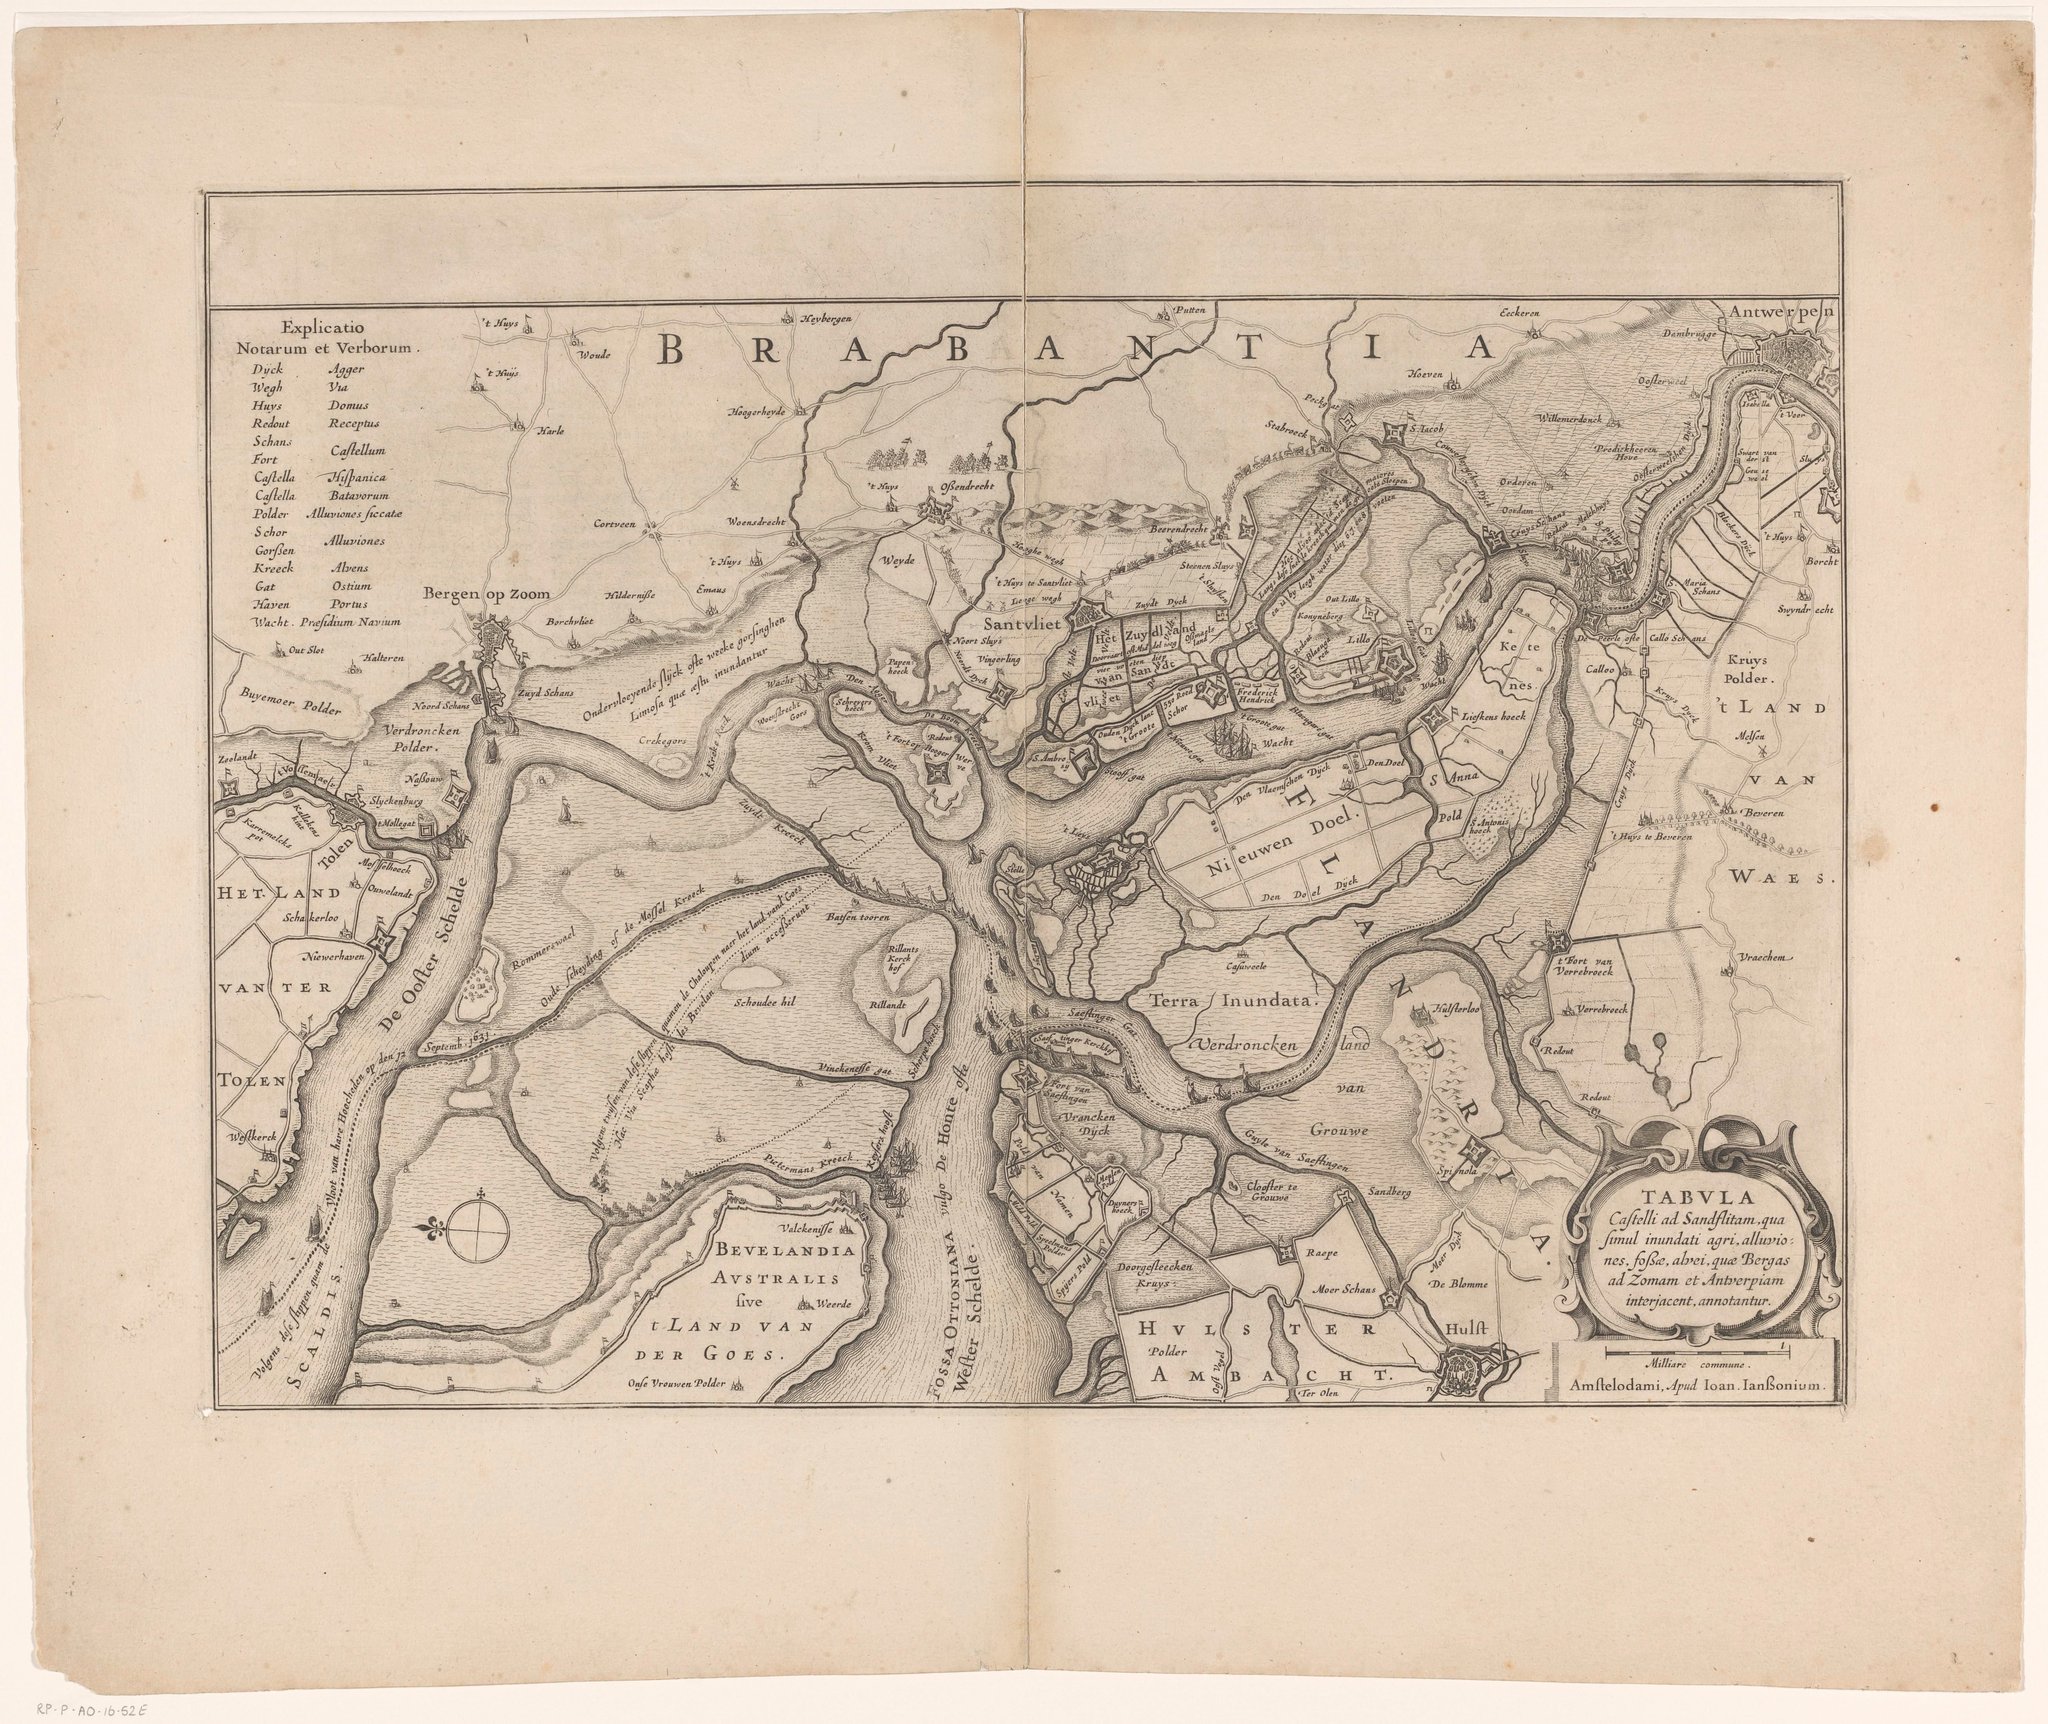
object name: print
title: Tabula castelli ad Sandflitam, qua simul inundati agri, alluviones, fossae, alvei, quae Bergas ad Zomam et Antverpiam interjacent, annotantur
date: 1652-1658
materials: paper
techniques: engraving, etching, letterpress printing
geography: amsterdam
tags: delft, the hague, frederick henry (prince of orange), maps of separate countries or regions, antwerp, bergen op zoom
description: Prent gebruikt in: Janssonius, Johannes. Nouvel Atlas ou Theatre du Monde (...). 5 delen. Amsterdam: Johannes Janssonius, 1652-1653, dl. 2. Of in: Janssonius, Johannes. Nouvel Atlas ou Theatre du Monde (...). 6 delen. Amsterdam: Johannes Janssonius, 1656-1658, dl. 2. Deze prent is een kopie van een prent van Blaeu, ook gebruikt in: Groot, Hugo de. Grollae obsidio cum annexis anni 1627. Amsterdam: Willem Jansz. Blaeu, 1629. En van 1630 tot 1672 in verschillende atlassen uitgegeven door Willem Jansz. en zijn zoon Johannes Blaeu.